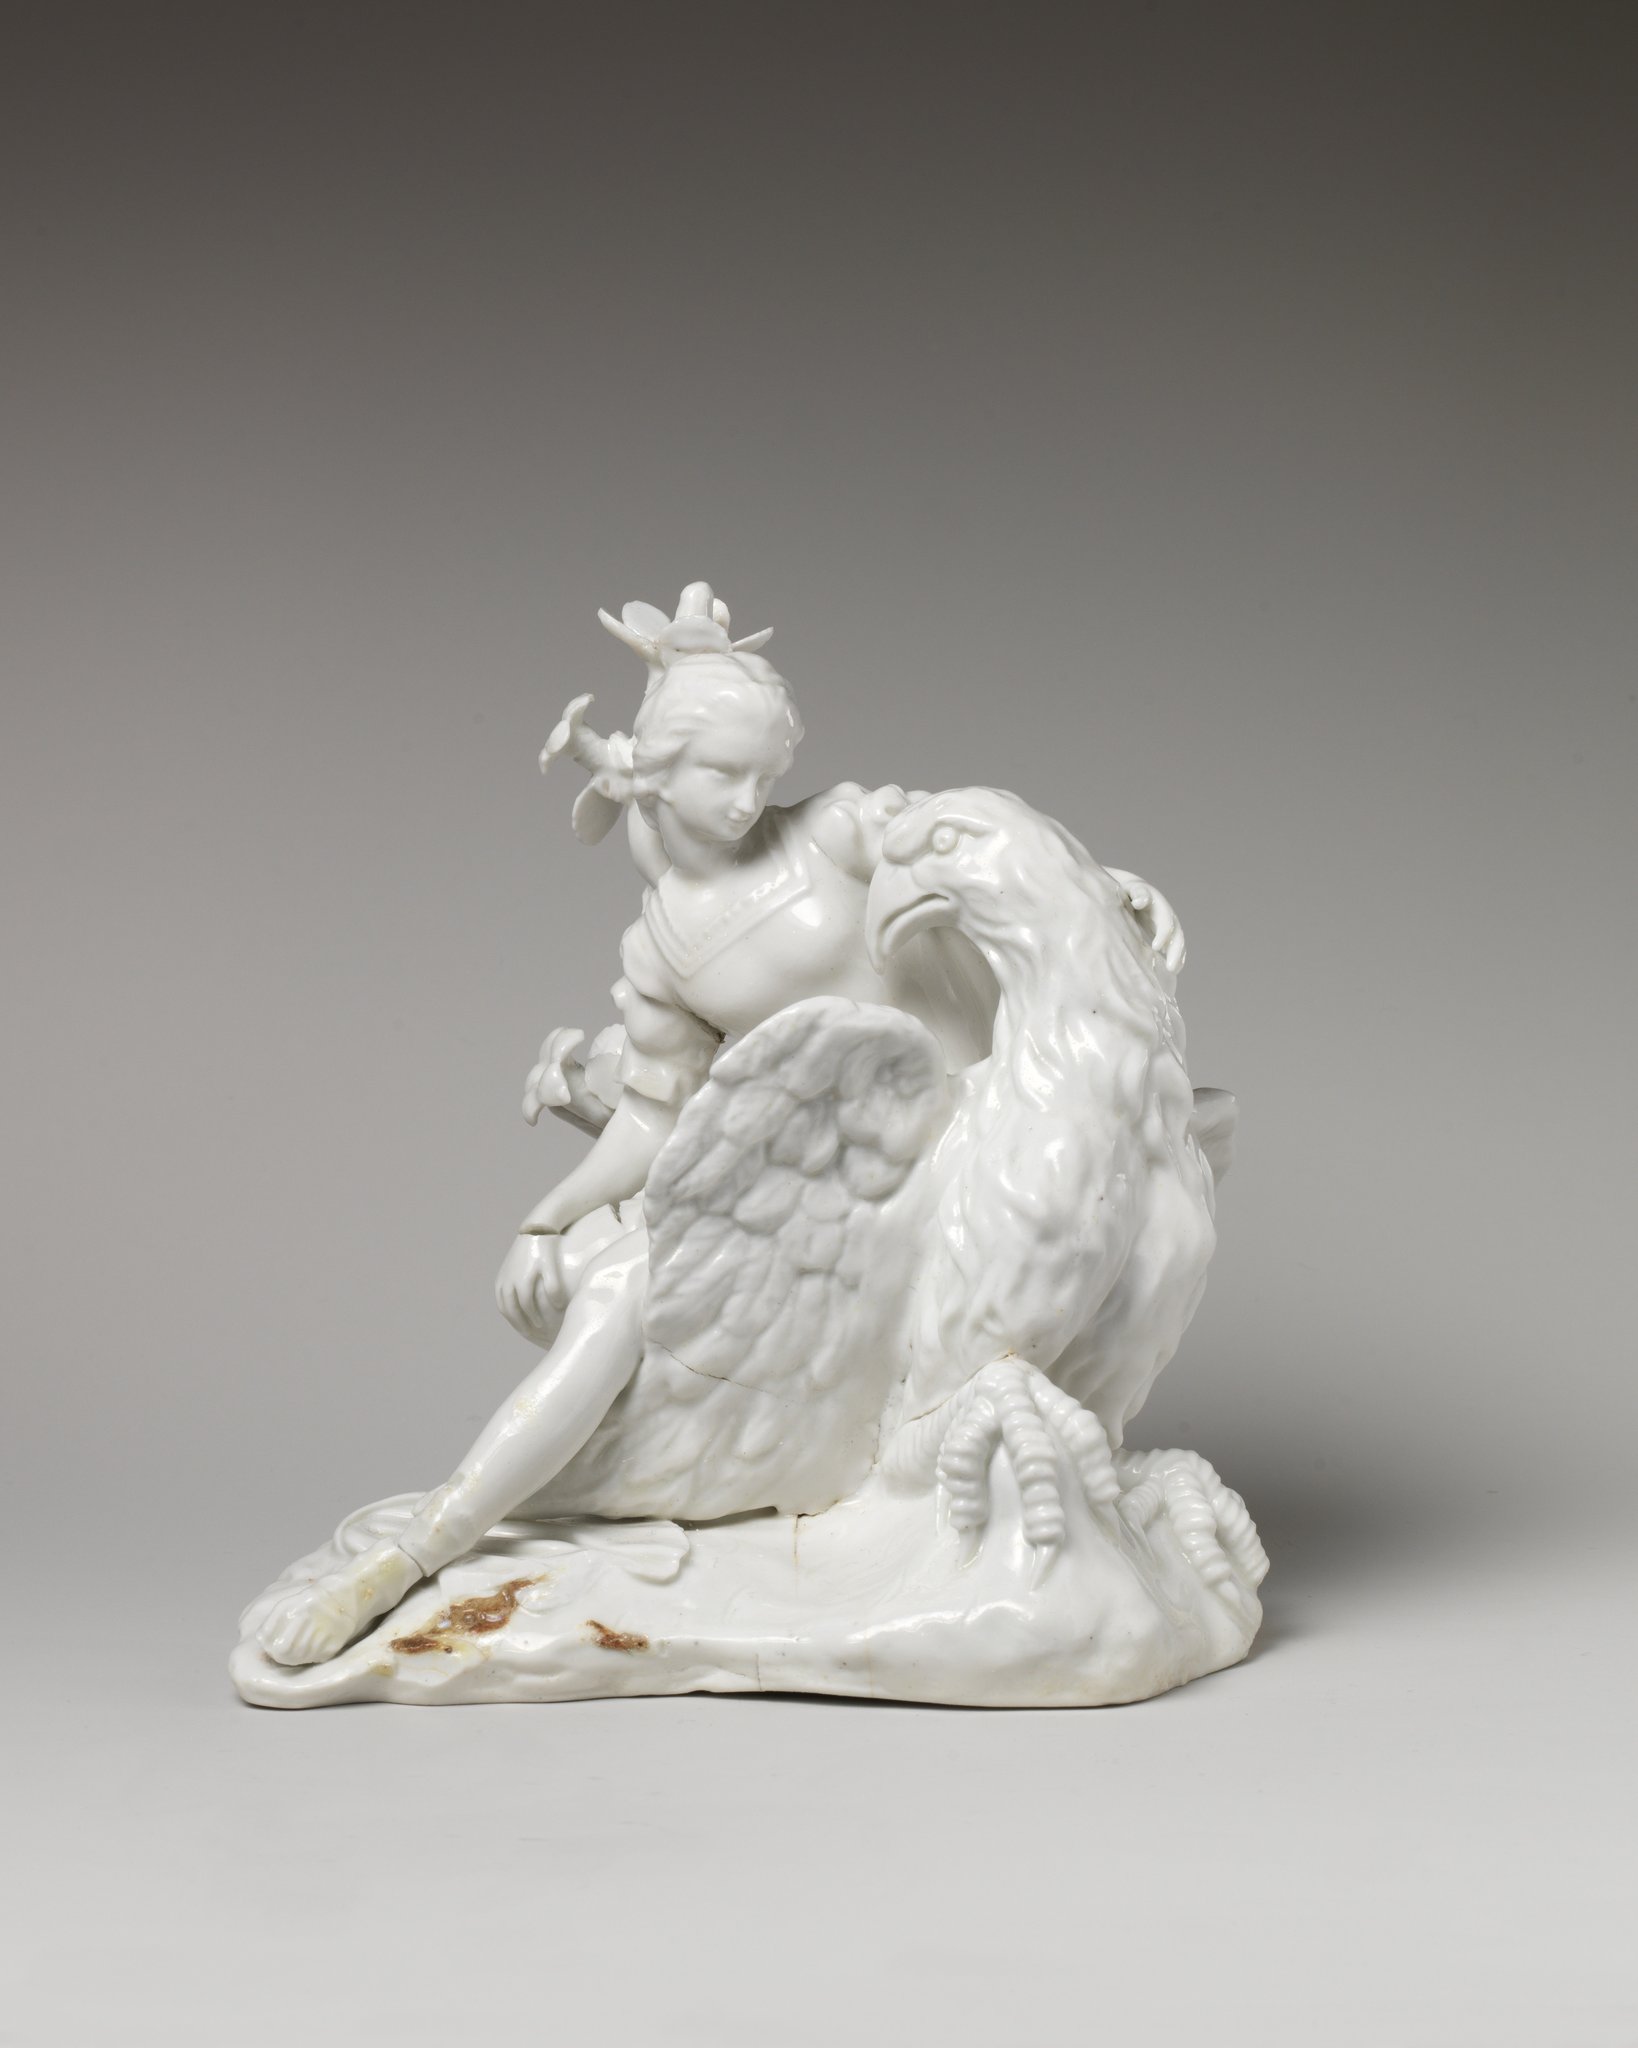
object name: candlestick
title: Ganymede and the Eagle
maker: saint james's factory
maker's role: maker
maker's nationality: british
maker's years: 1749-1759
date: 1750-1760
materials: soft paste porcelain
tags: eagles,men